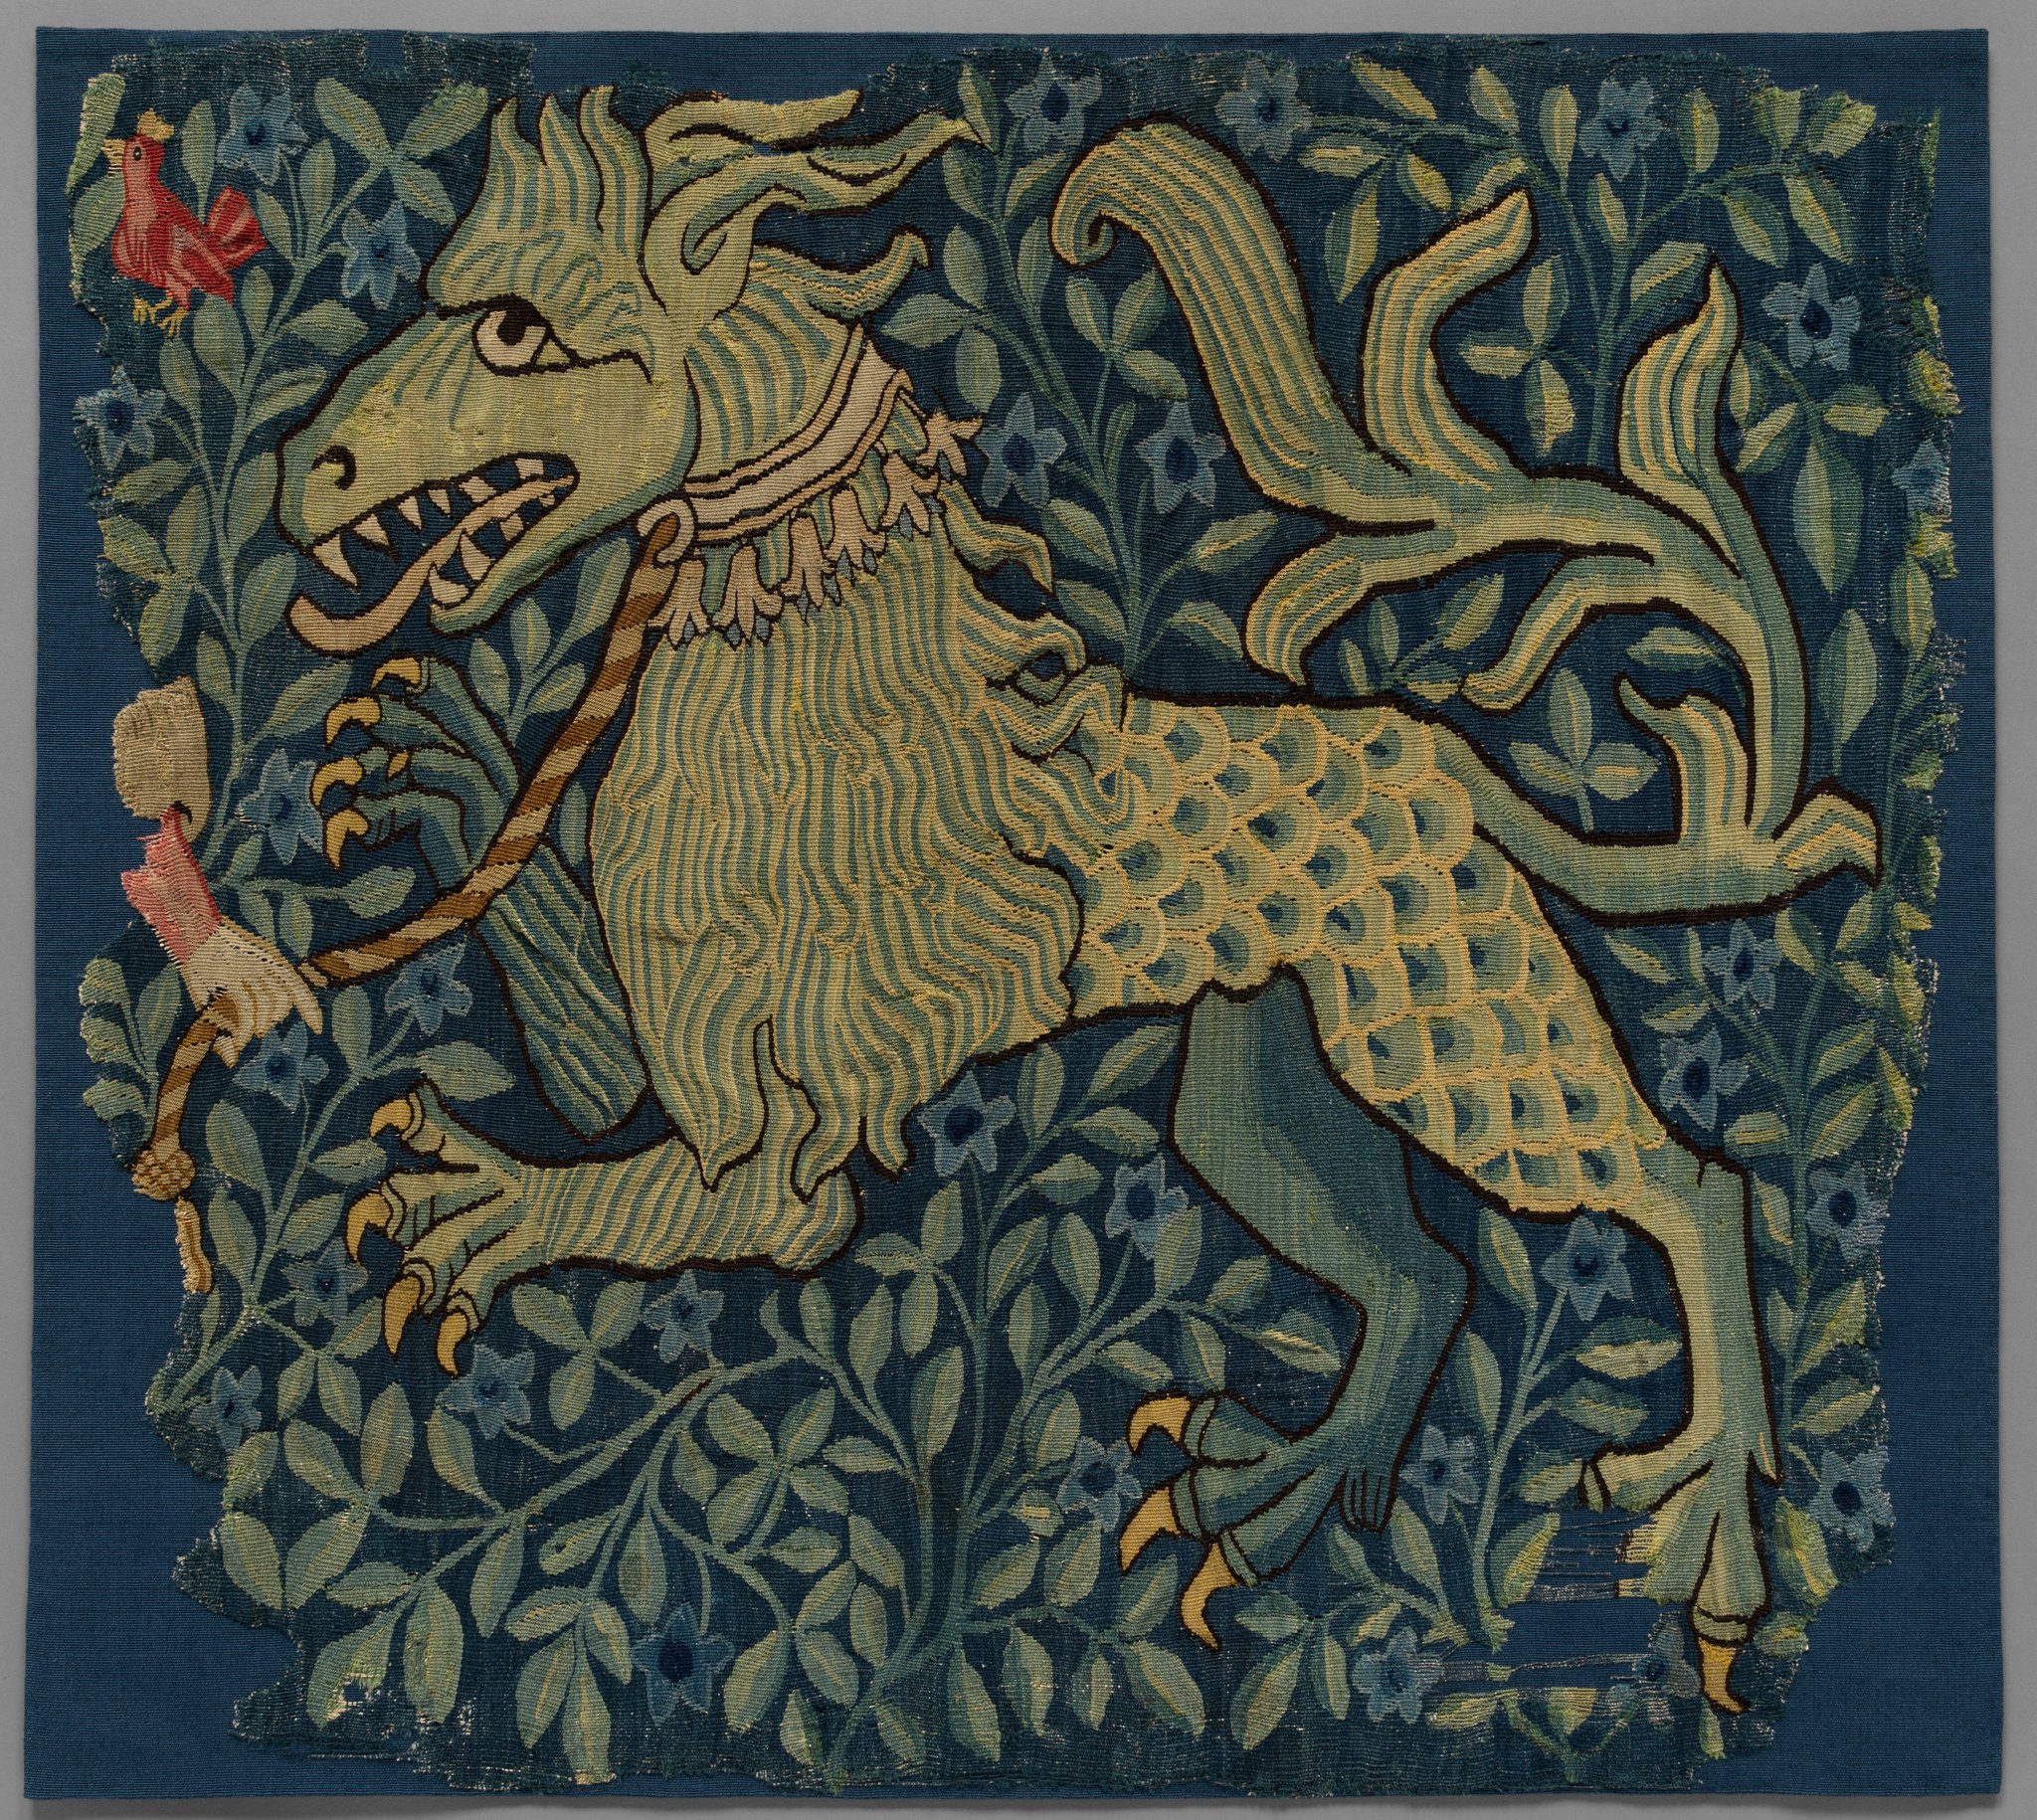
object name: tapestry fragment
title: Fragment of a Tapestry or Wall Hanging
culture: upper rhenish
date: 1420-1430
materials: linen, wool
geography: switzerland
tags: birds,mythical creatures